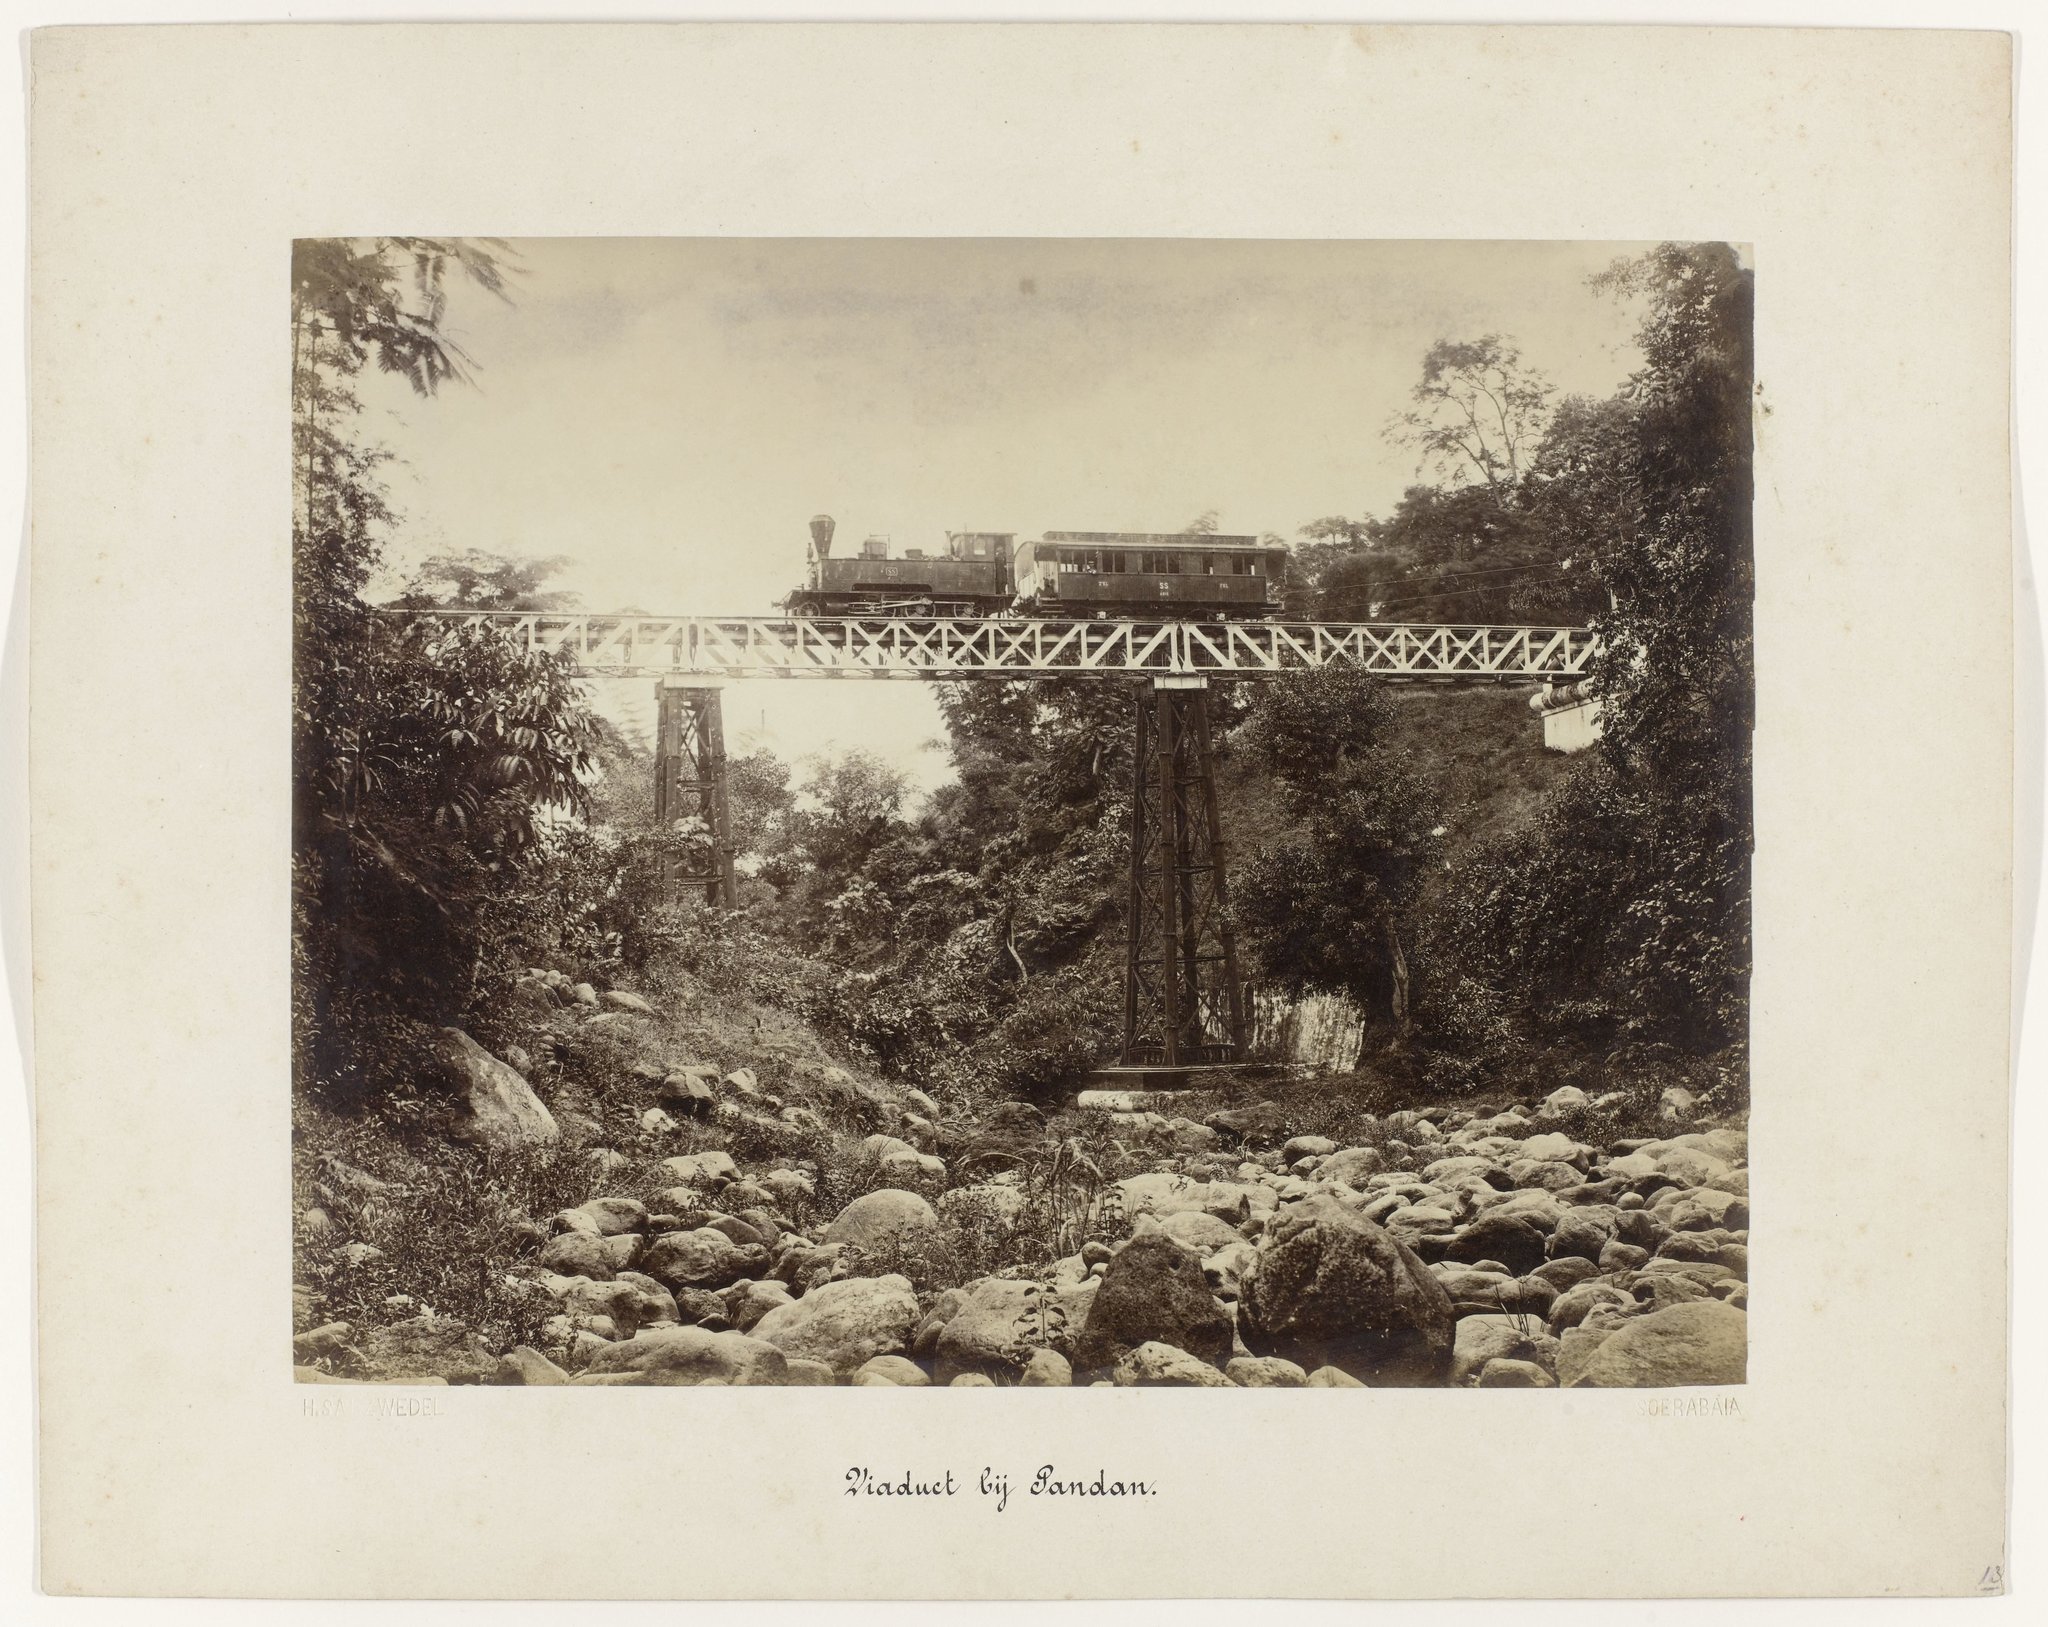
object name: photograph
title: Staatsspoorwegen op Java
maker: herman salzwedel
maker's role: fotograaf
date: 1880-1888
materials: photographic support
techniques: albumen print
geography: surabaya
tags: sandan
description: Een viaduct of spoorwegbrug over een ravijn of drooggevallen rivierbedding bij Pandan. Op de brug staat een trein met een passagierswagon. Onderdeel van een groep van 62 foto's in een doos met het opschrift "Staatsspoorwegen op Java" uit 1888.